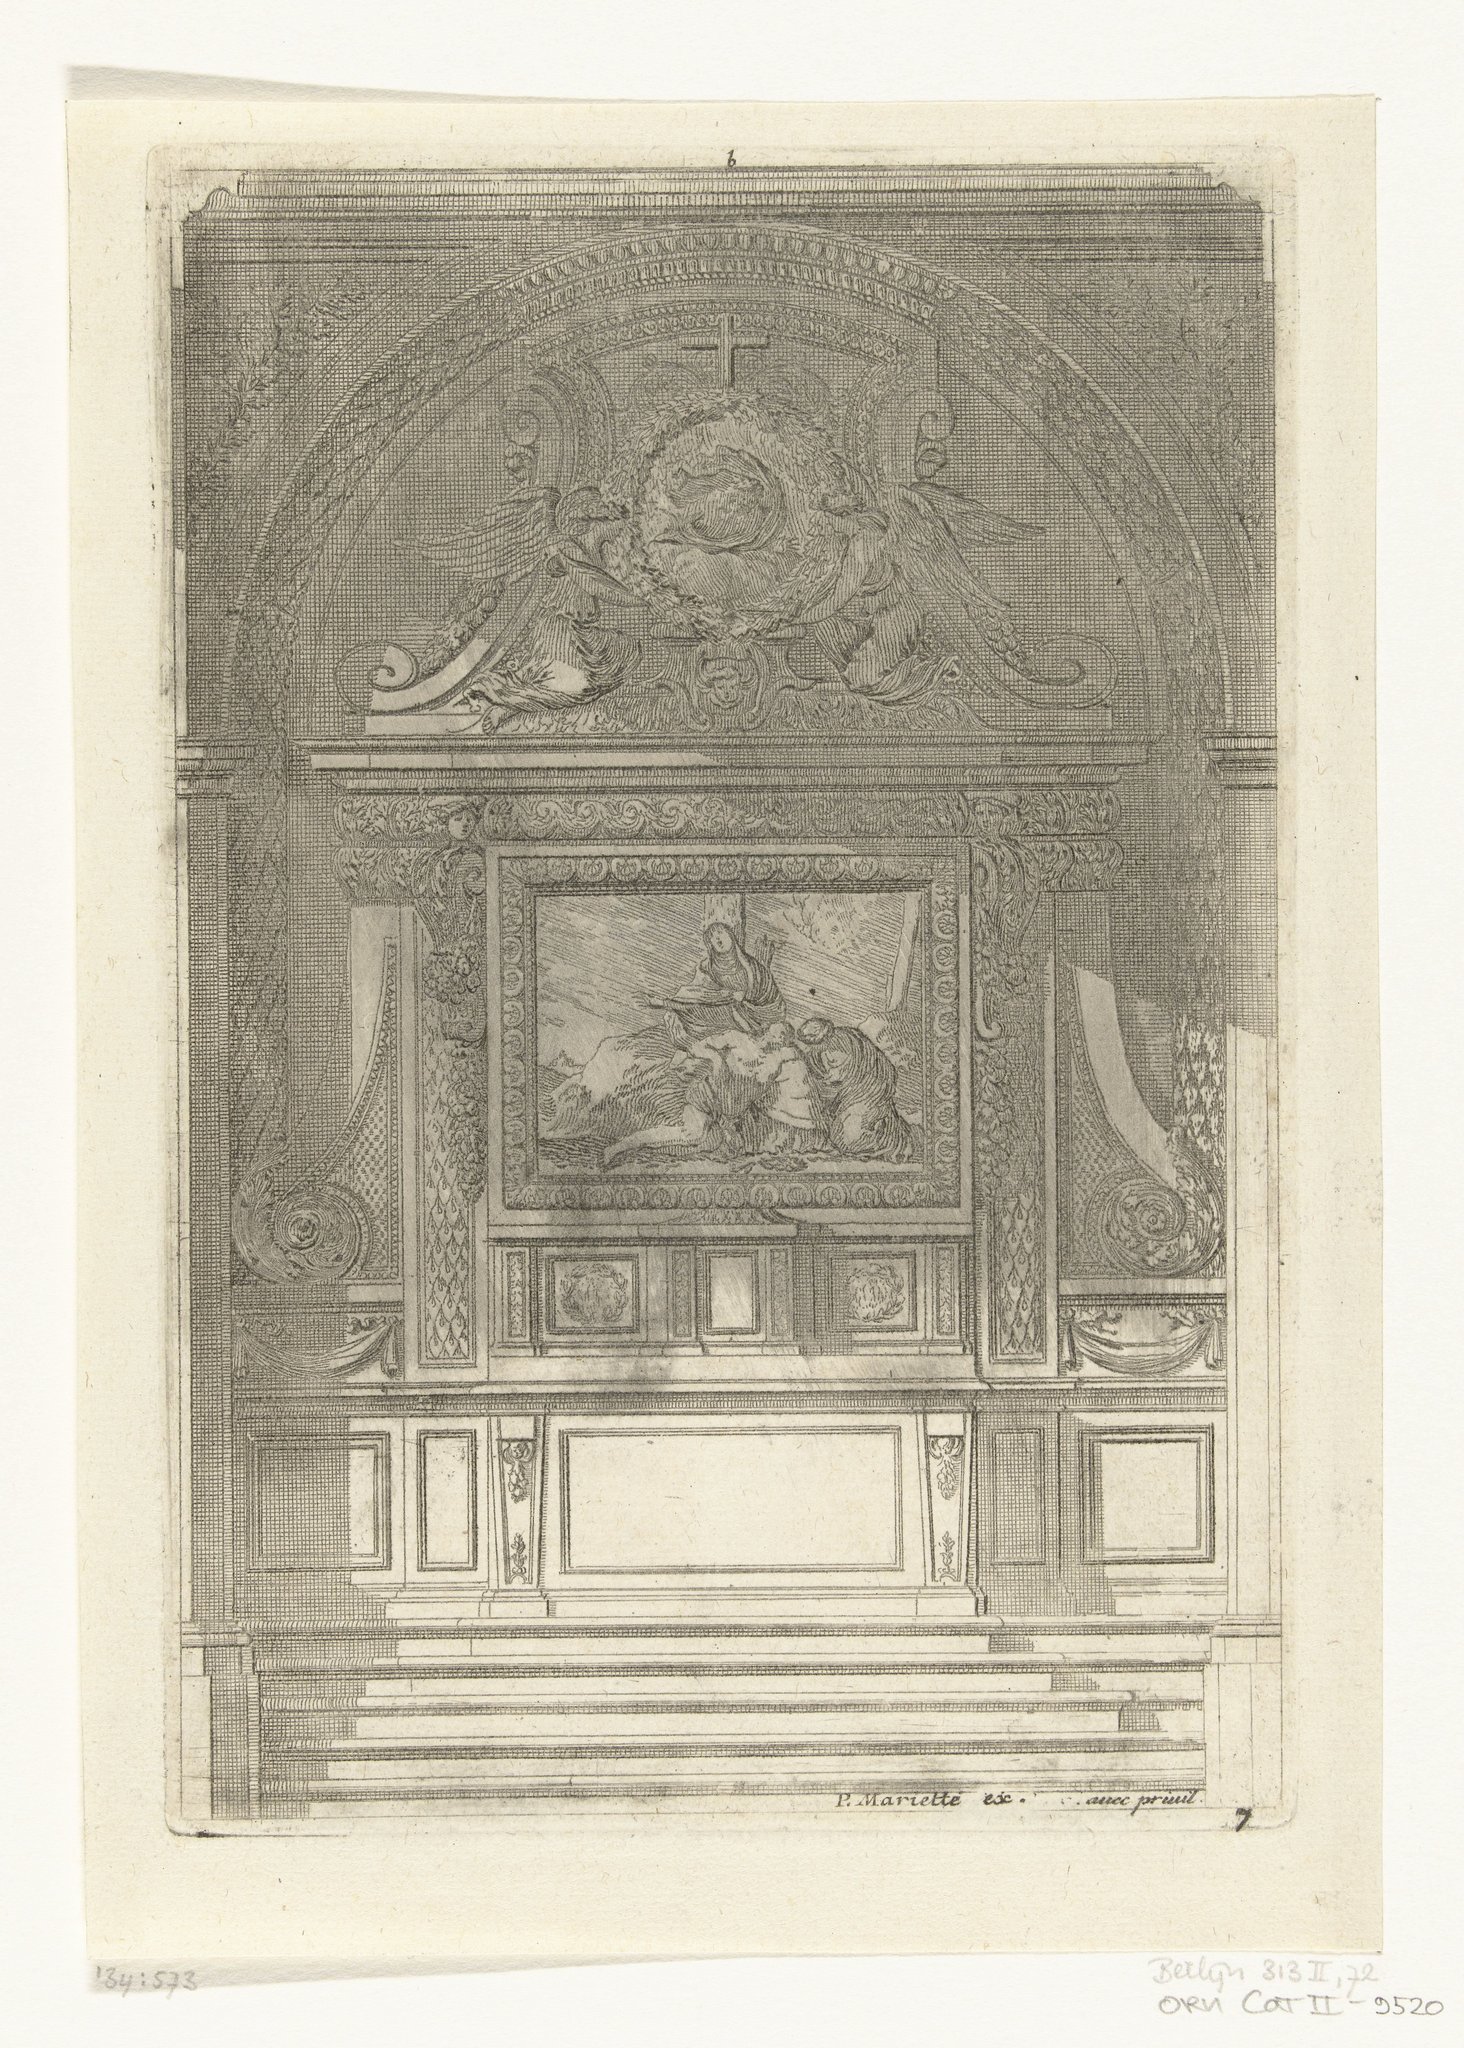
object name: ornament print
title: Authels et Retables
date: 1666-1693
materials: paper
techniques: etching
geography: paris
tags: lamentation over the dead christ by his relatives and friends (christ usually without crown of thorns)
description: Uit tweede editie van serie met altaren en tabernakels.